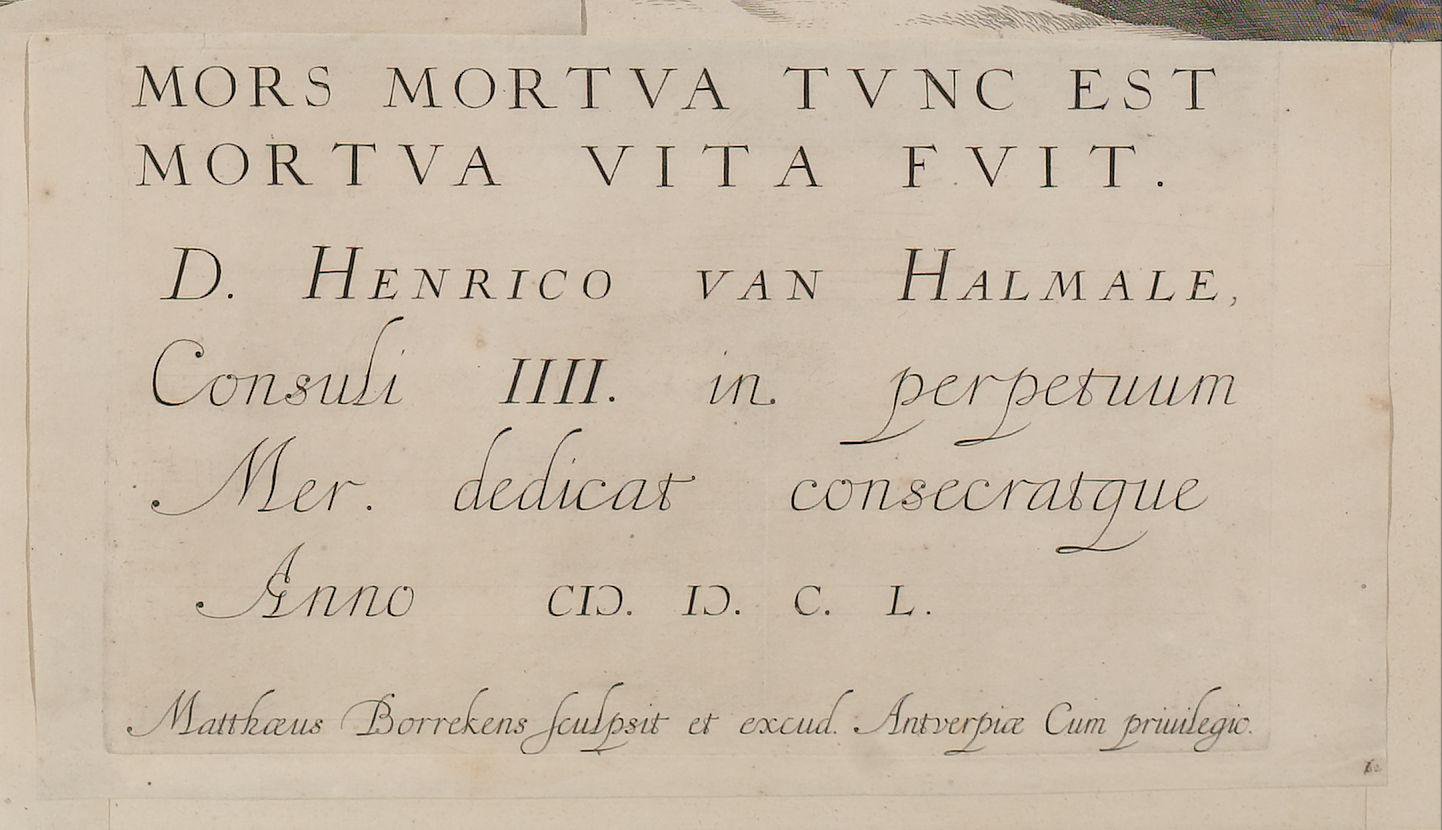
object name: text sheet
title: Tekstblad van de gekruisigde Christus met Maria, Johannes en Maria Magdelena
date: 1650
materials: paper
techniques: engraving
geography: antwerp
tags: crucified christ with mary, john, and mary magdalene, cupids: 'amores', 'amoretti', 'putti'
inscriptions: collector's mark: Lugt 1838, collector's mark: Lugt 240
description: Tekstblad met het Latijns opschrift: 'O Magnum Pietatis Opus/ Mors mortua tunc est/ Pro nobis postquam/ Motrua vita fuit'.